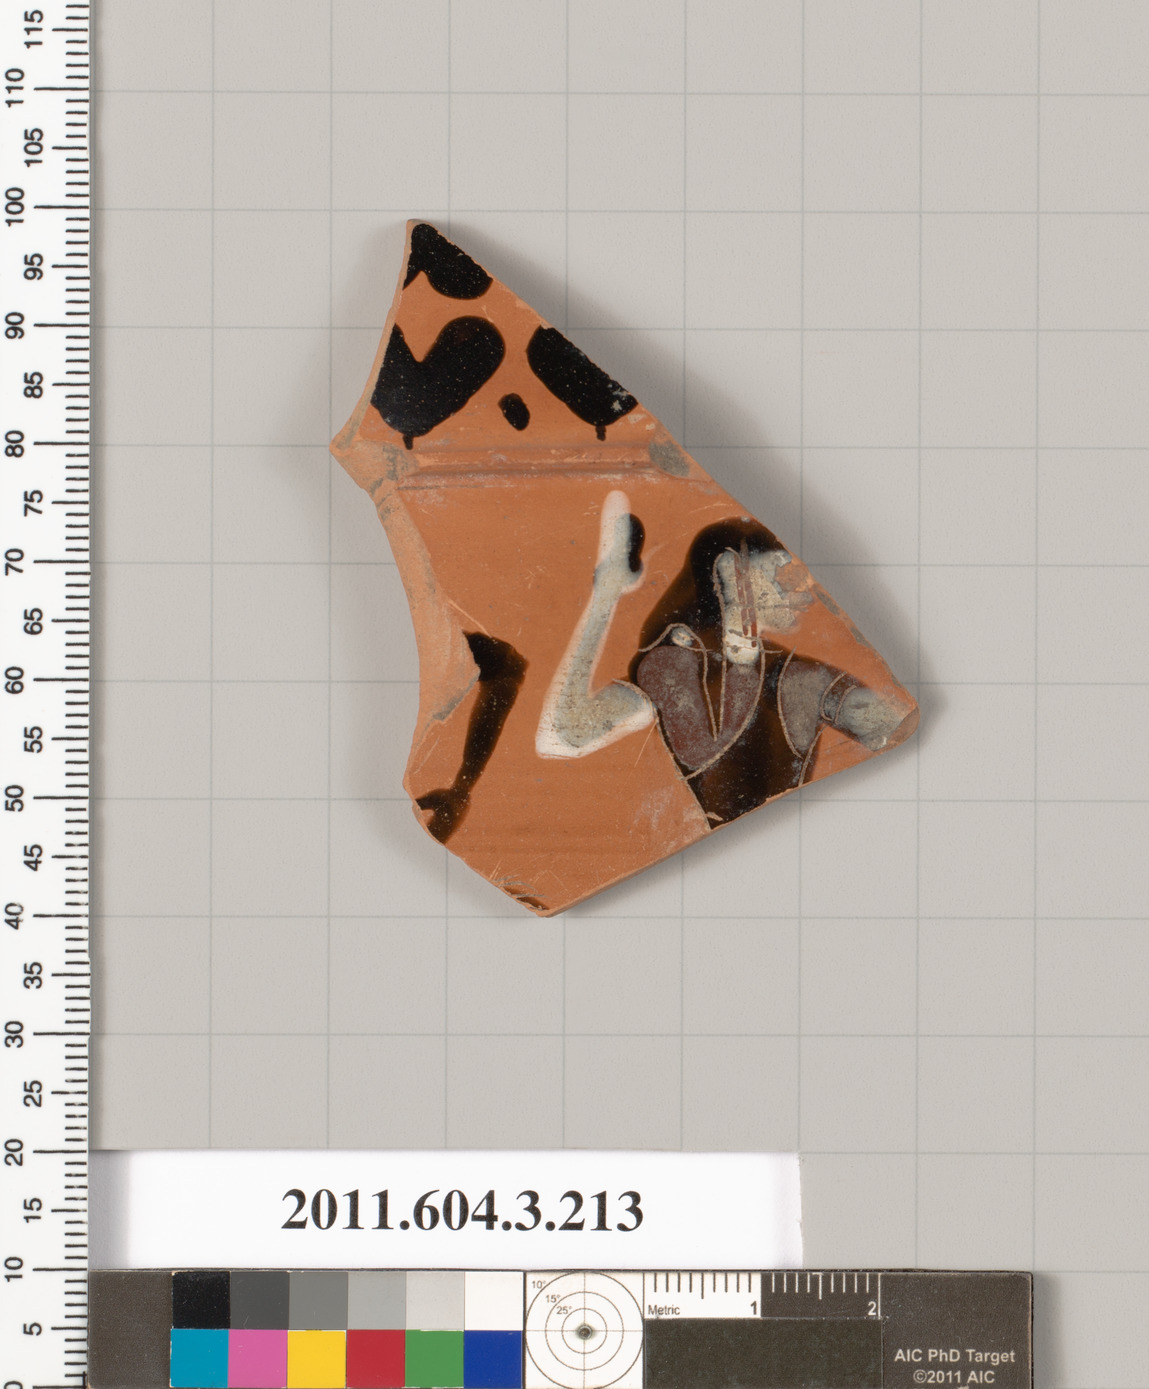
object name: neck amphora fragment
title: Terracotta fragment of a neck-amphora of Nicosthenic shape (jar)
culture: greek, attic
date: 525-501 BCE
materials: terracotta